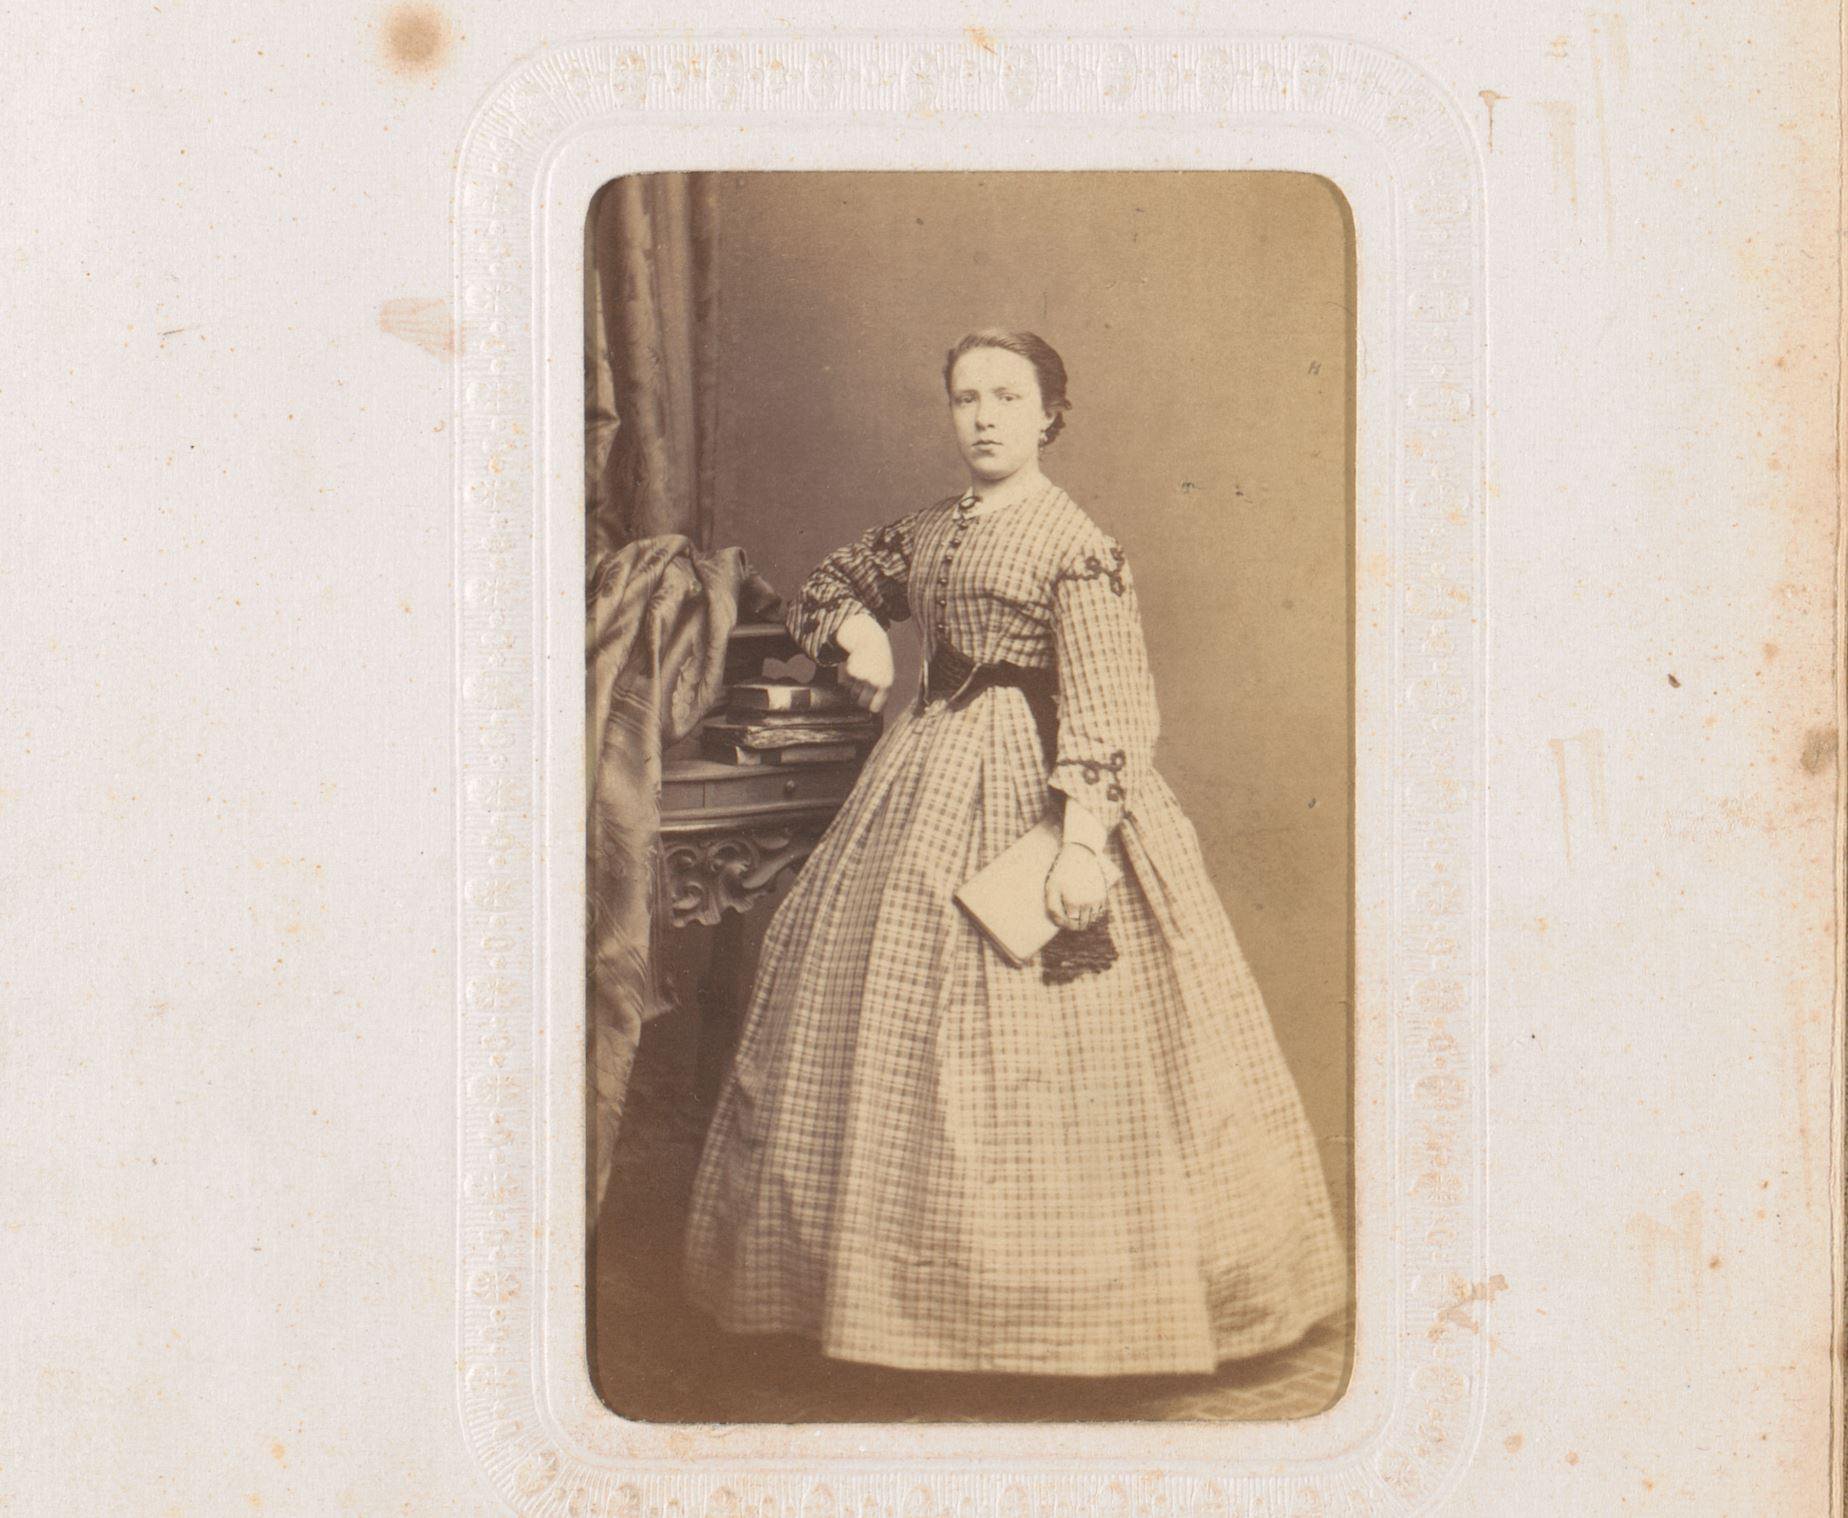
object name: album leaf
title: Portret van een staande jonge vrouw met boek in de hand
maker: Anonymous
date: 1860-1900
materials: cardboard, photographic support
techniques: albumen print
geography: netherlands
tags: adolescent, young woman, maiden, historical persons - bb - woman, book, standing figure - aa - female human figure